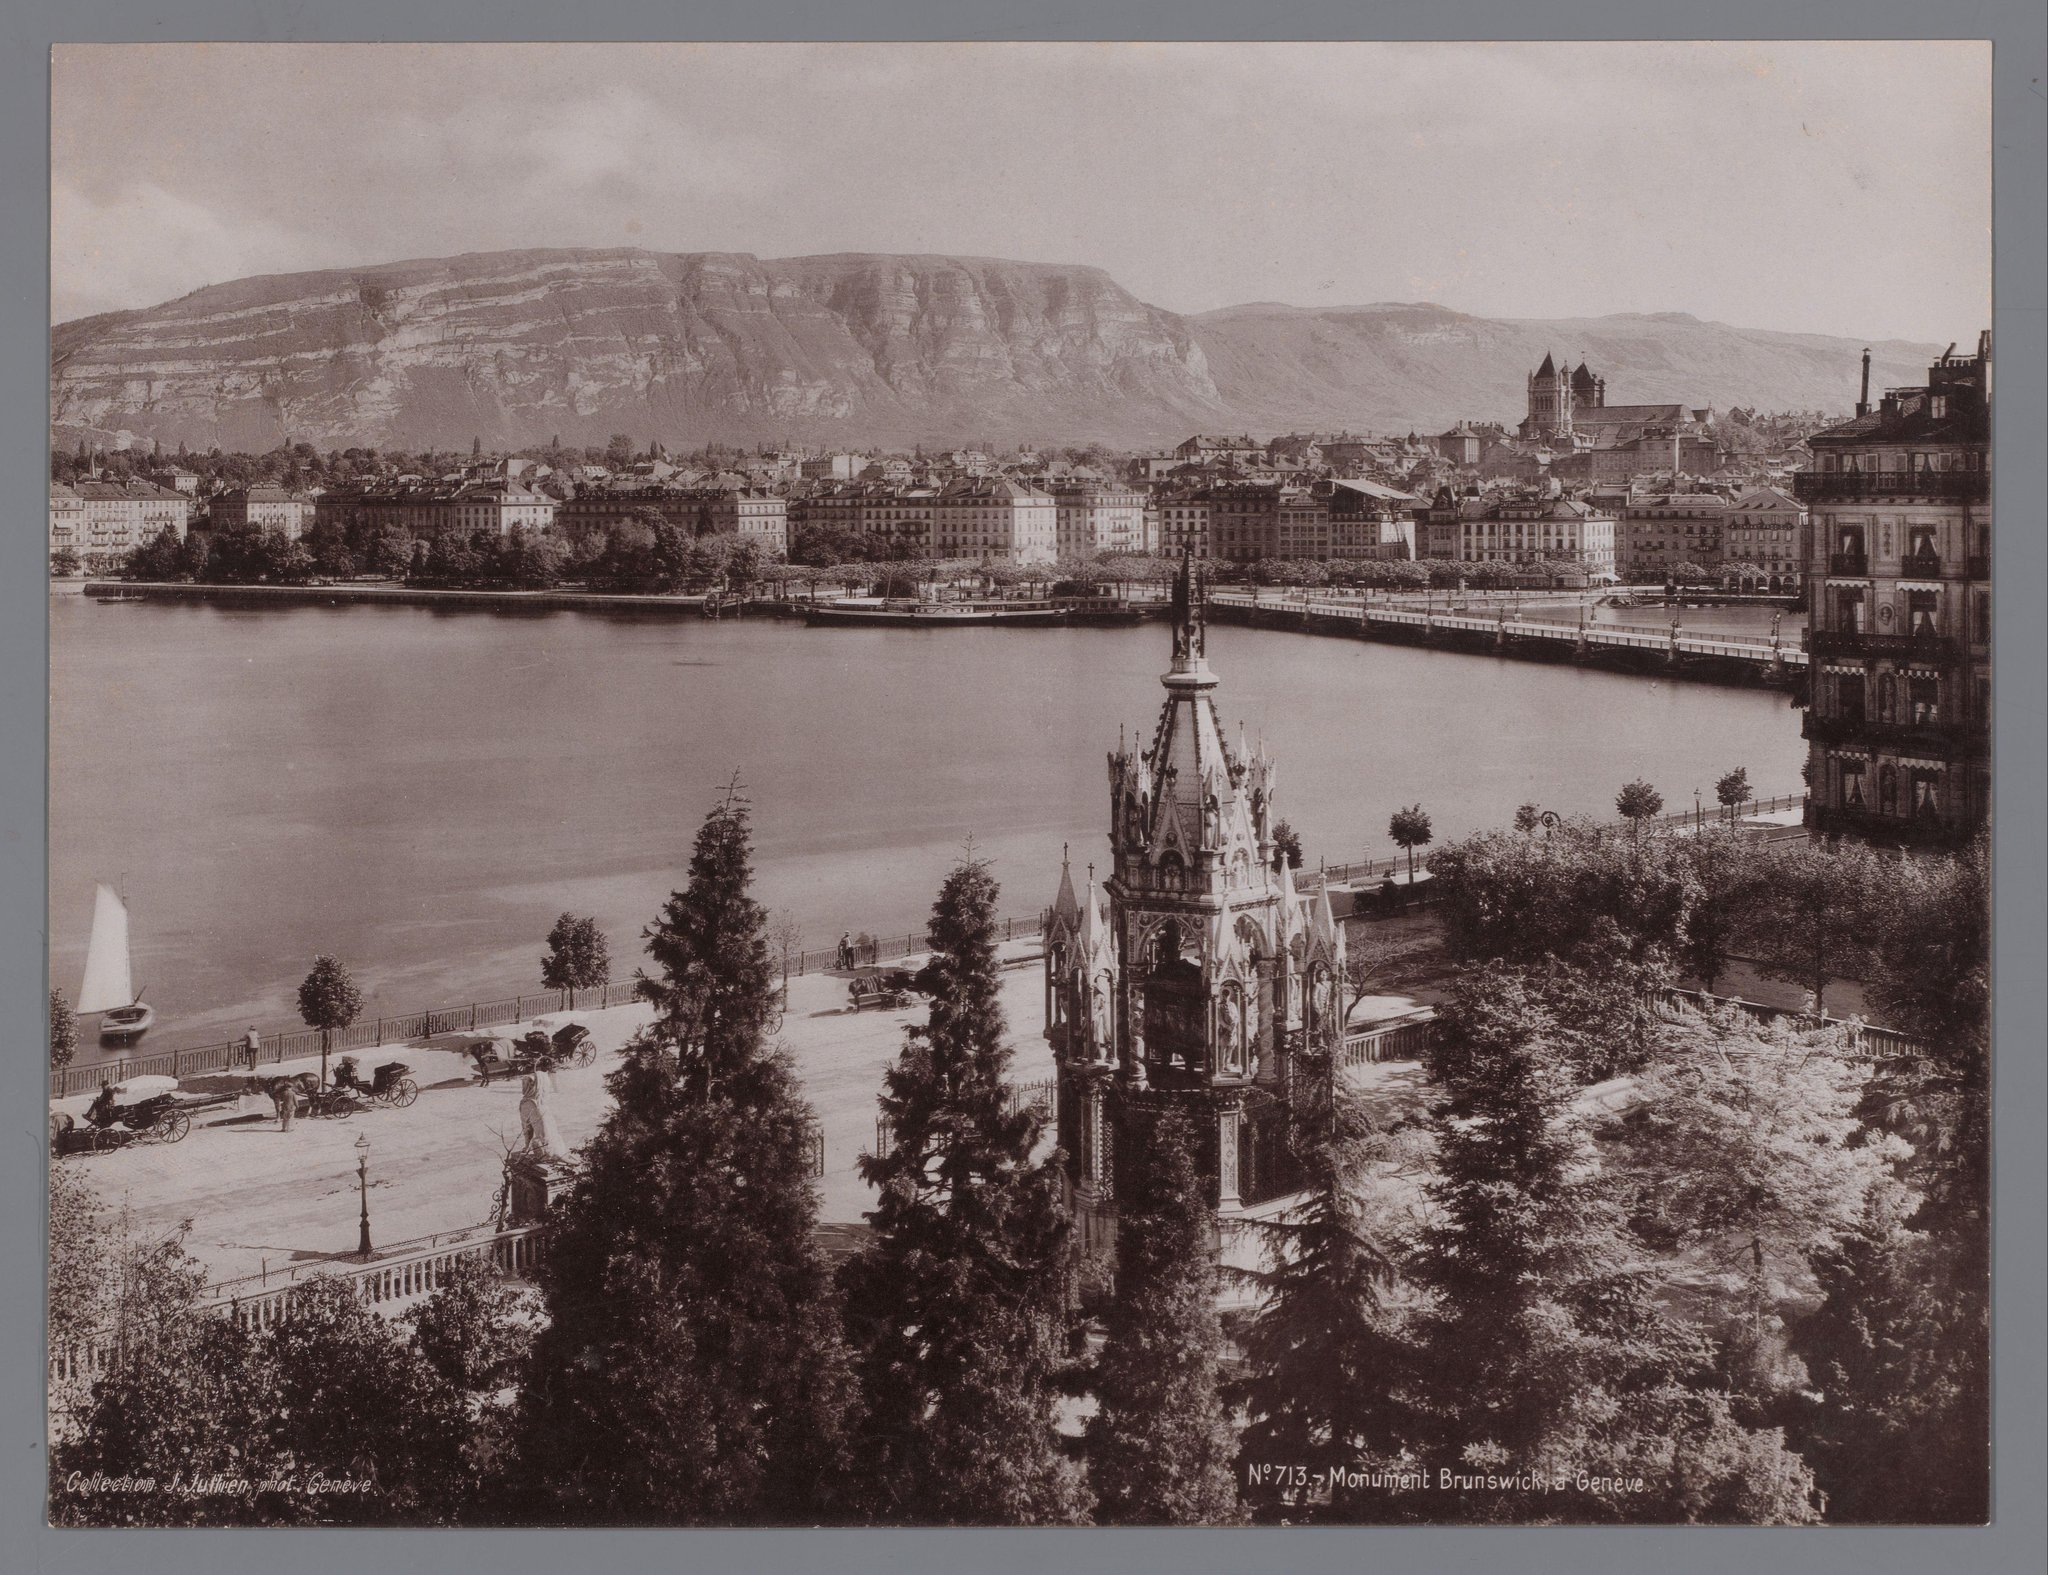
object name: photograph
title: Brunswick-monument, Genève, Zwitserland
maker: jean-henri jullien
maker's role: publisher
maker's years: 1818-1887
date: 1890-1915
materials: paper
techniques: photograph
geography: switzerland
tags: genève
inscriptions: inscription: ‘Collection J. Jullien, phot. Genève’, inscription: ‘No. 173 - Monument Brunswick, à Genève’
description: Mausoleum uit 1879, ter nagedachtenis aan hertog Charles II de Brunswick (1804-1873). Replica van "Arche scaligere", Verona, Italië.